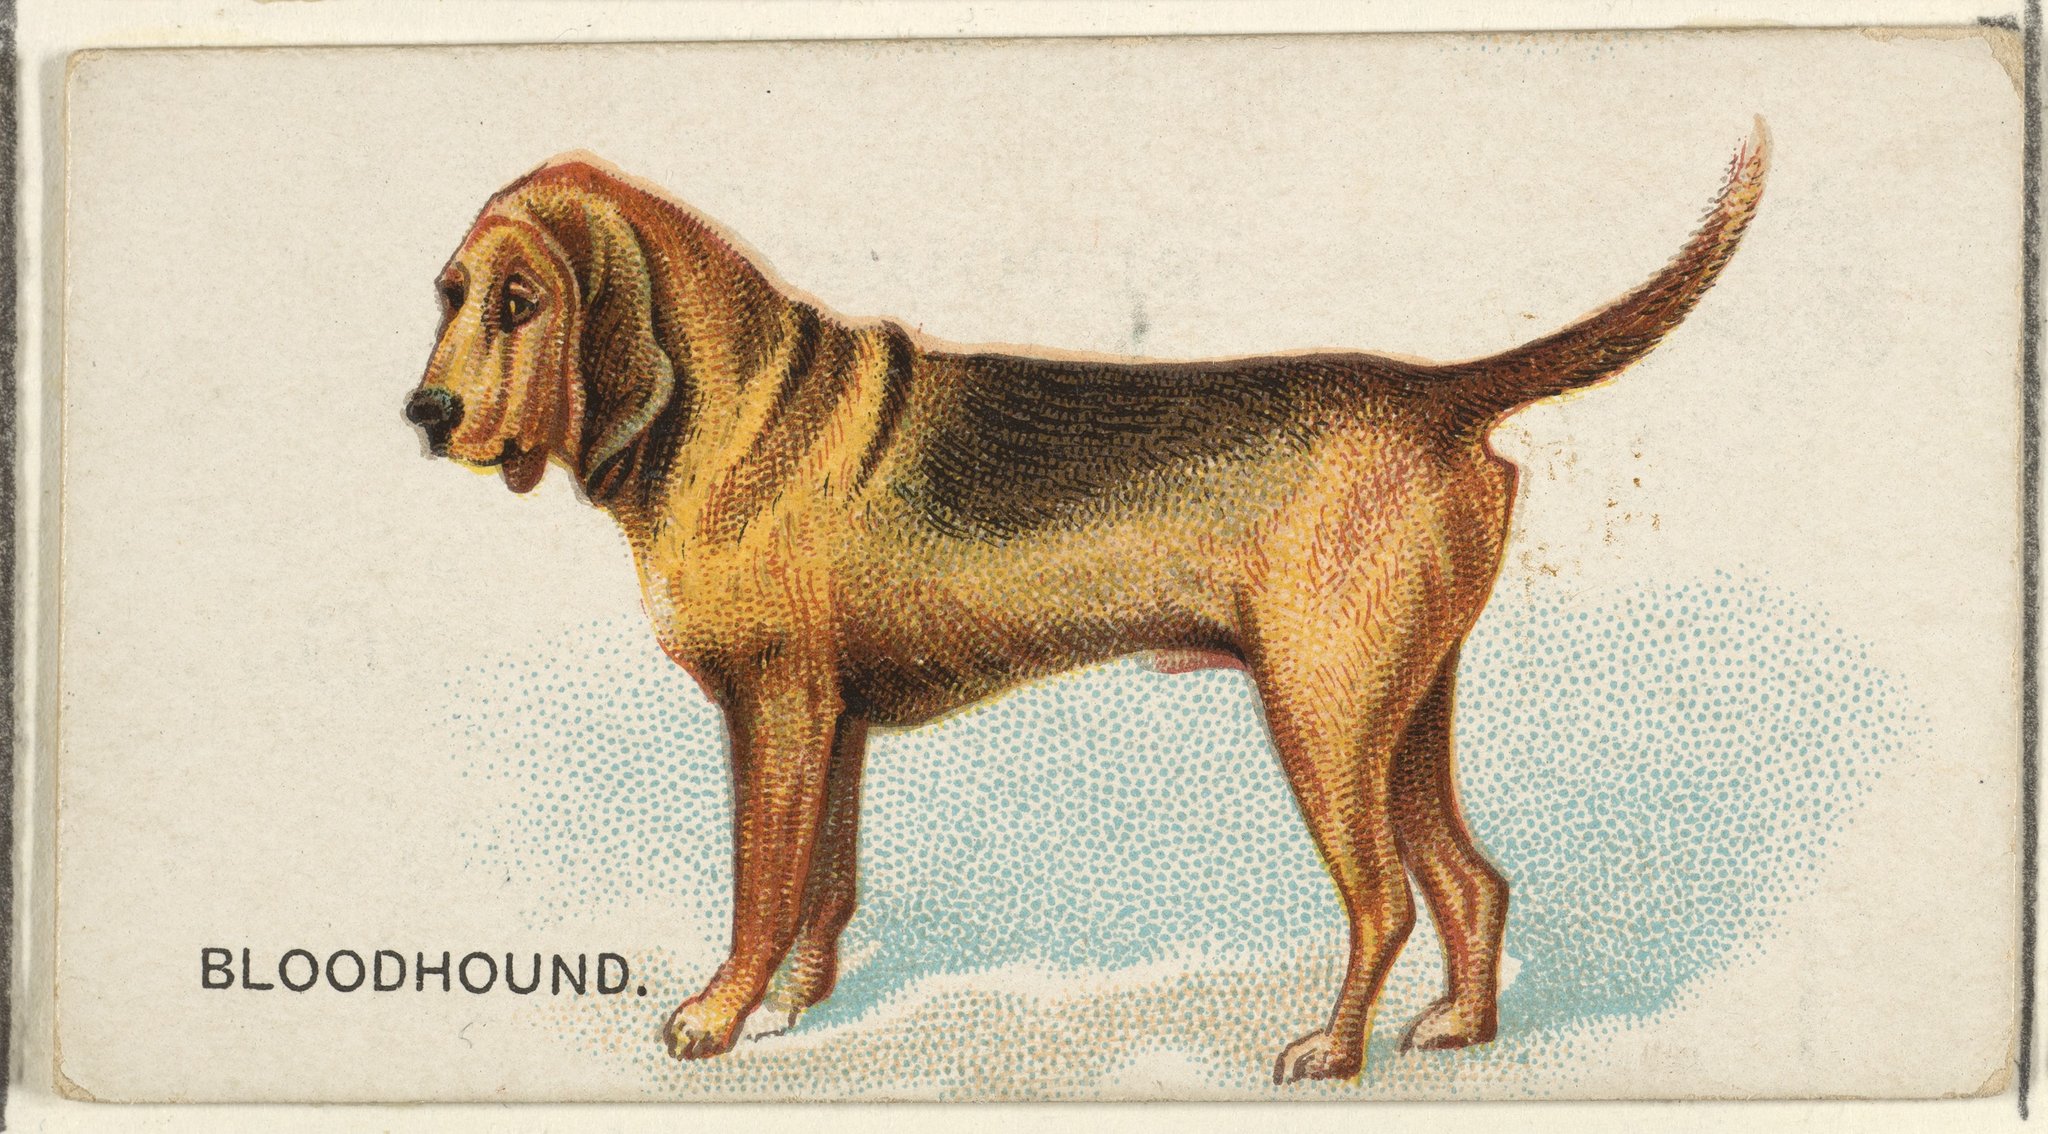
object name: print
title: Bloodhound, from the Dogs of the World series for Old Judge Cigarettes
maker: goodwin & company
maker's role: publisher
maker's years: 1850-1950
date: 1890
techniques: color lithograph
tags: dogs